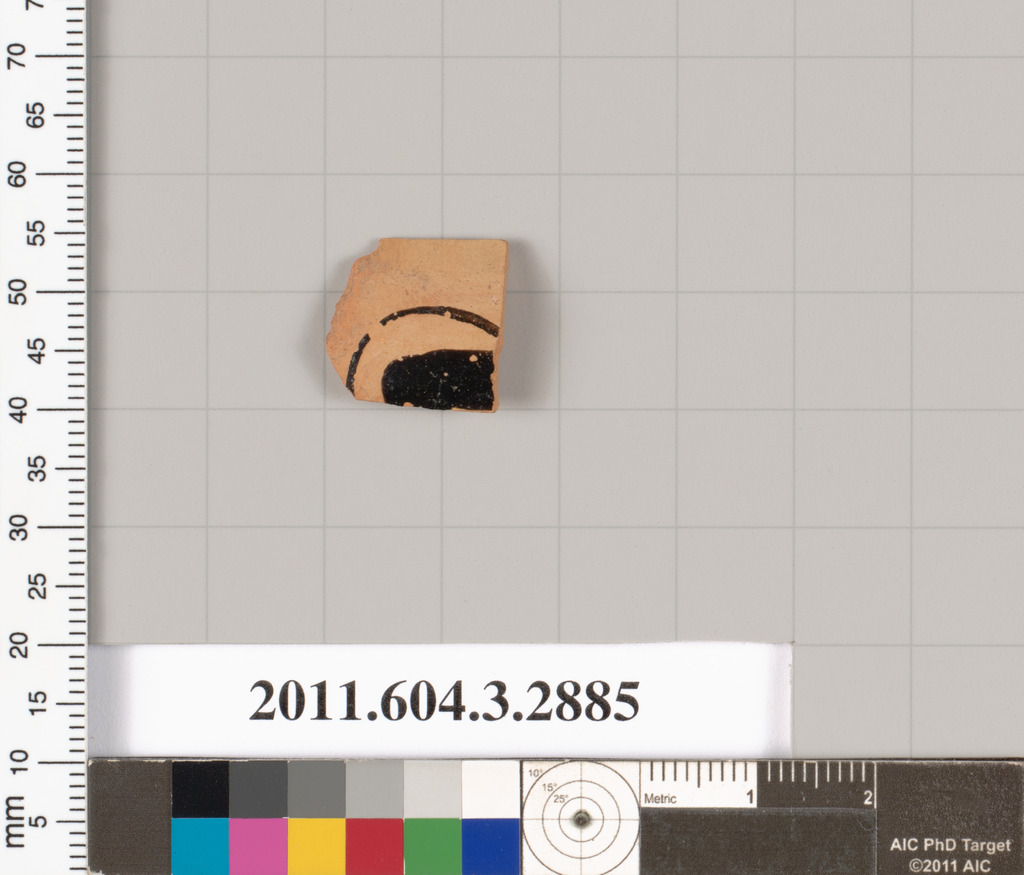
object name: undetermined closed shape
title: Terracotta fragment of a closed shape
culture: greek, attic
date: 525-501 BCE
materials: terracotta